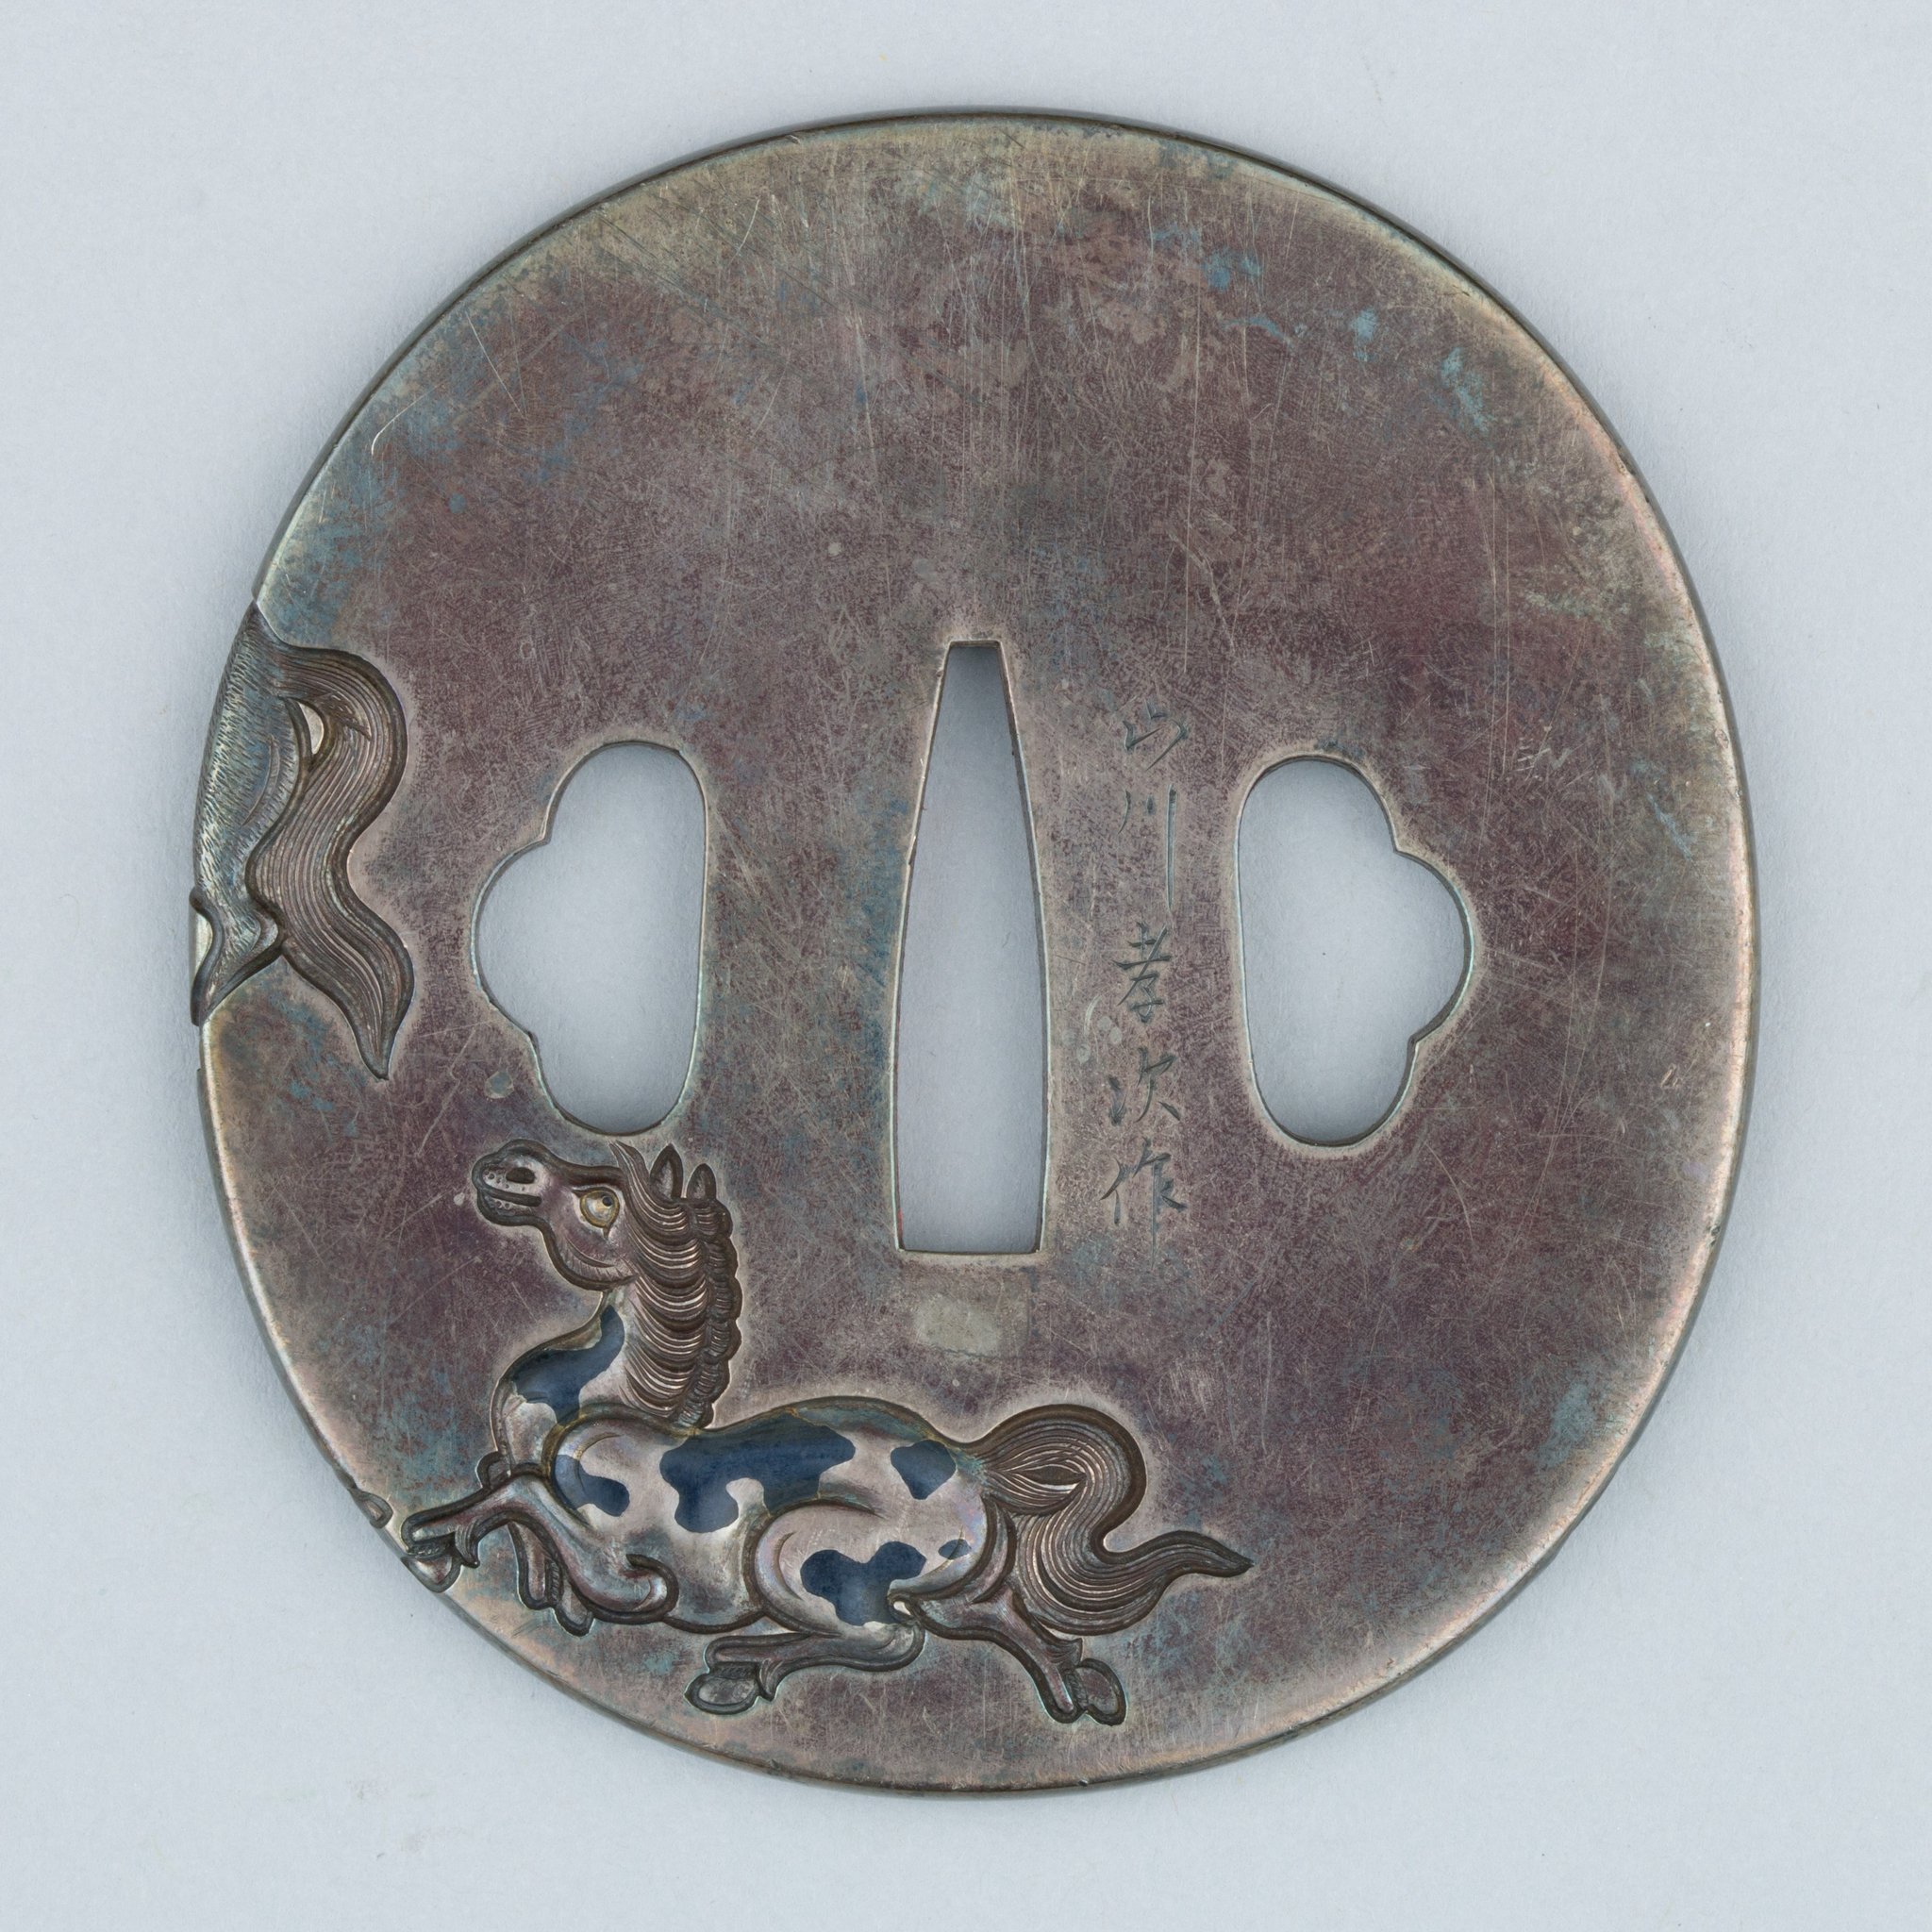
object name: sword guard tsuba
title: Sword Guard (Tsuba)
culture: japanese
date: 1615-1868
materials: copper, gold alloy, gold, silver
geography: japan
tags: horses